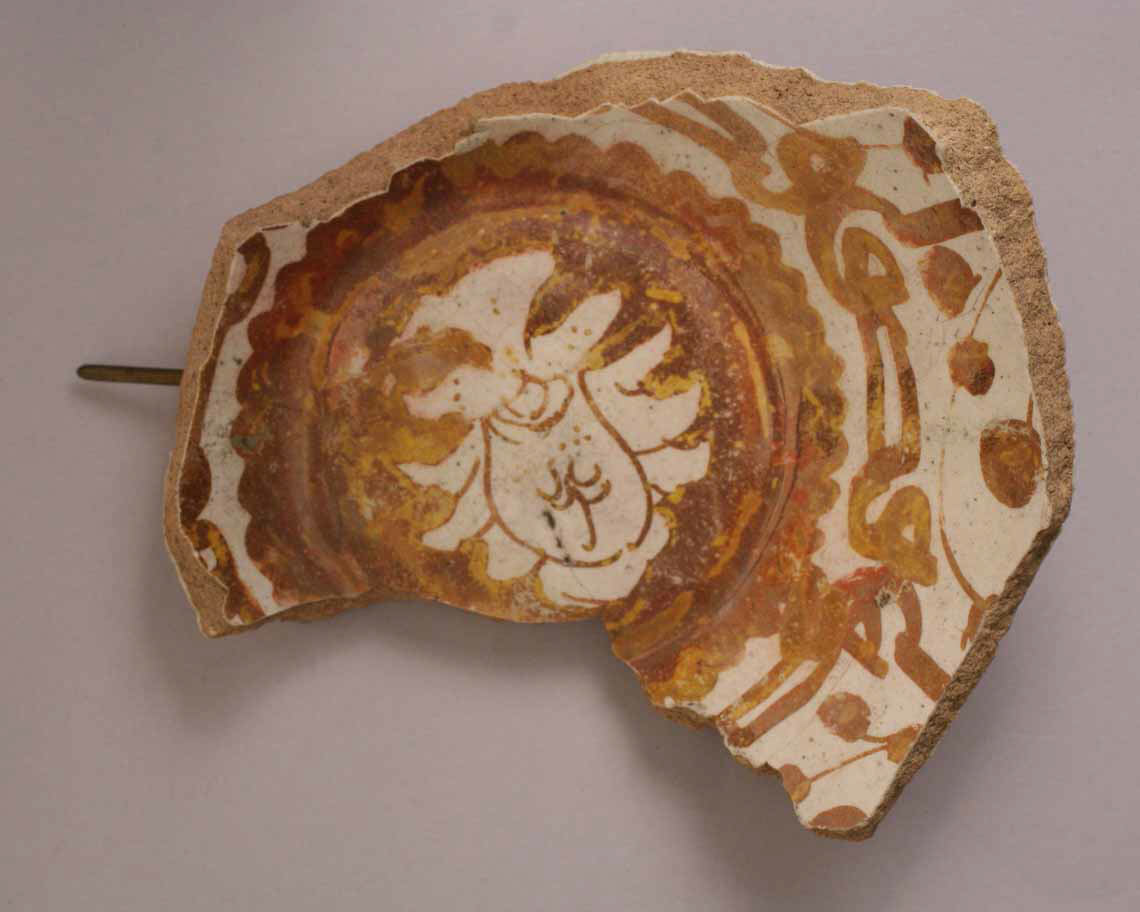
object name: ceramic fragment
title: Fragment of a Bowl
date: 1001-1200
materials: earthenware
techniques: luster painting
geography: egypt